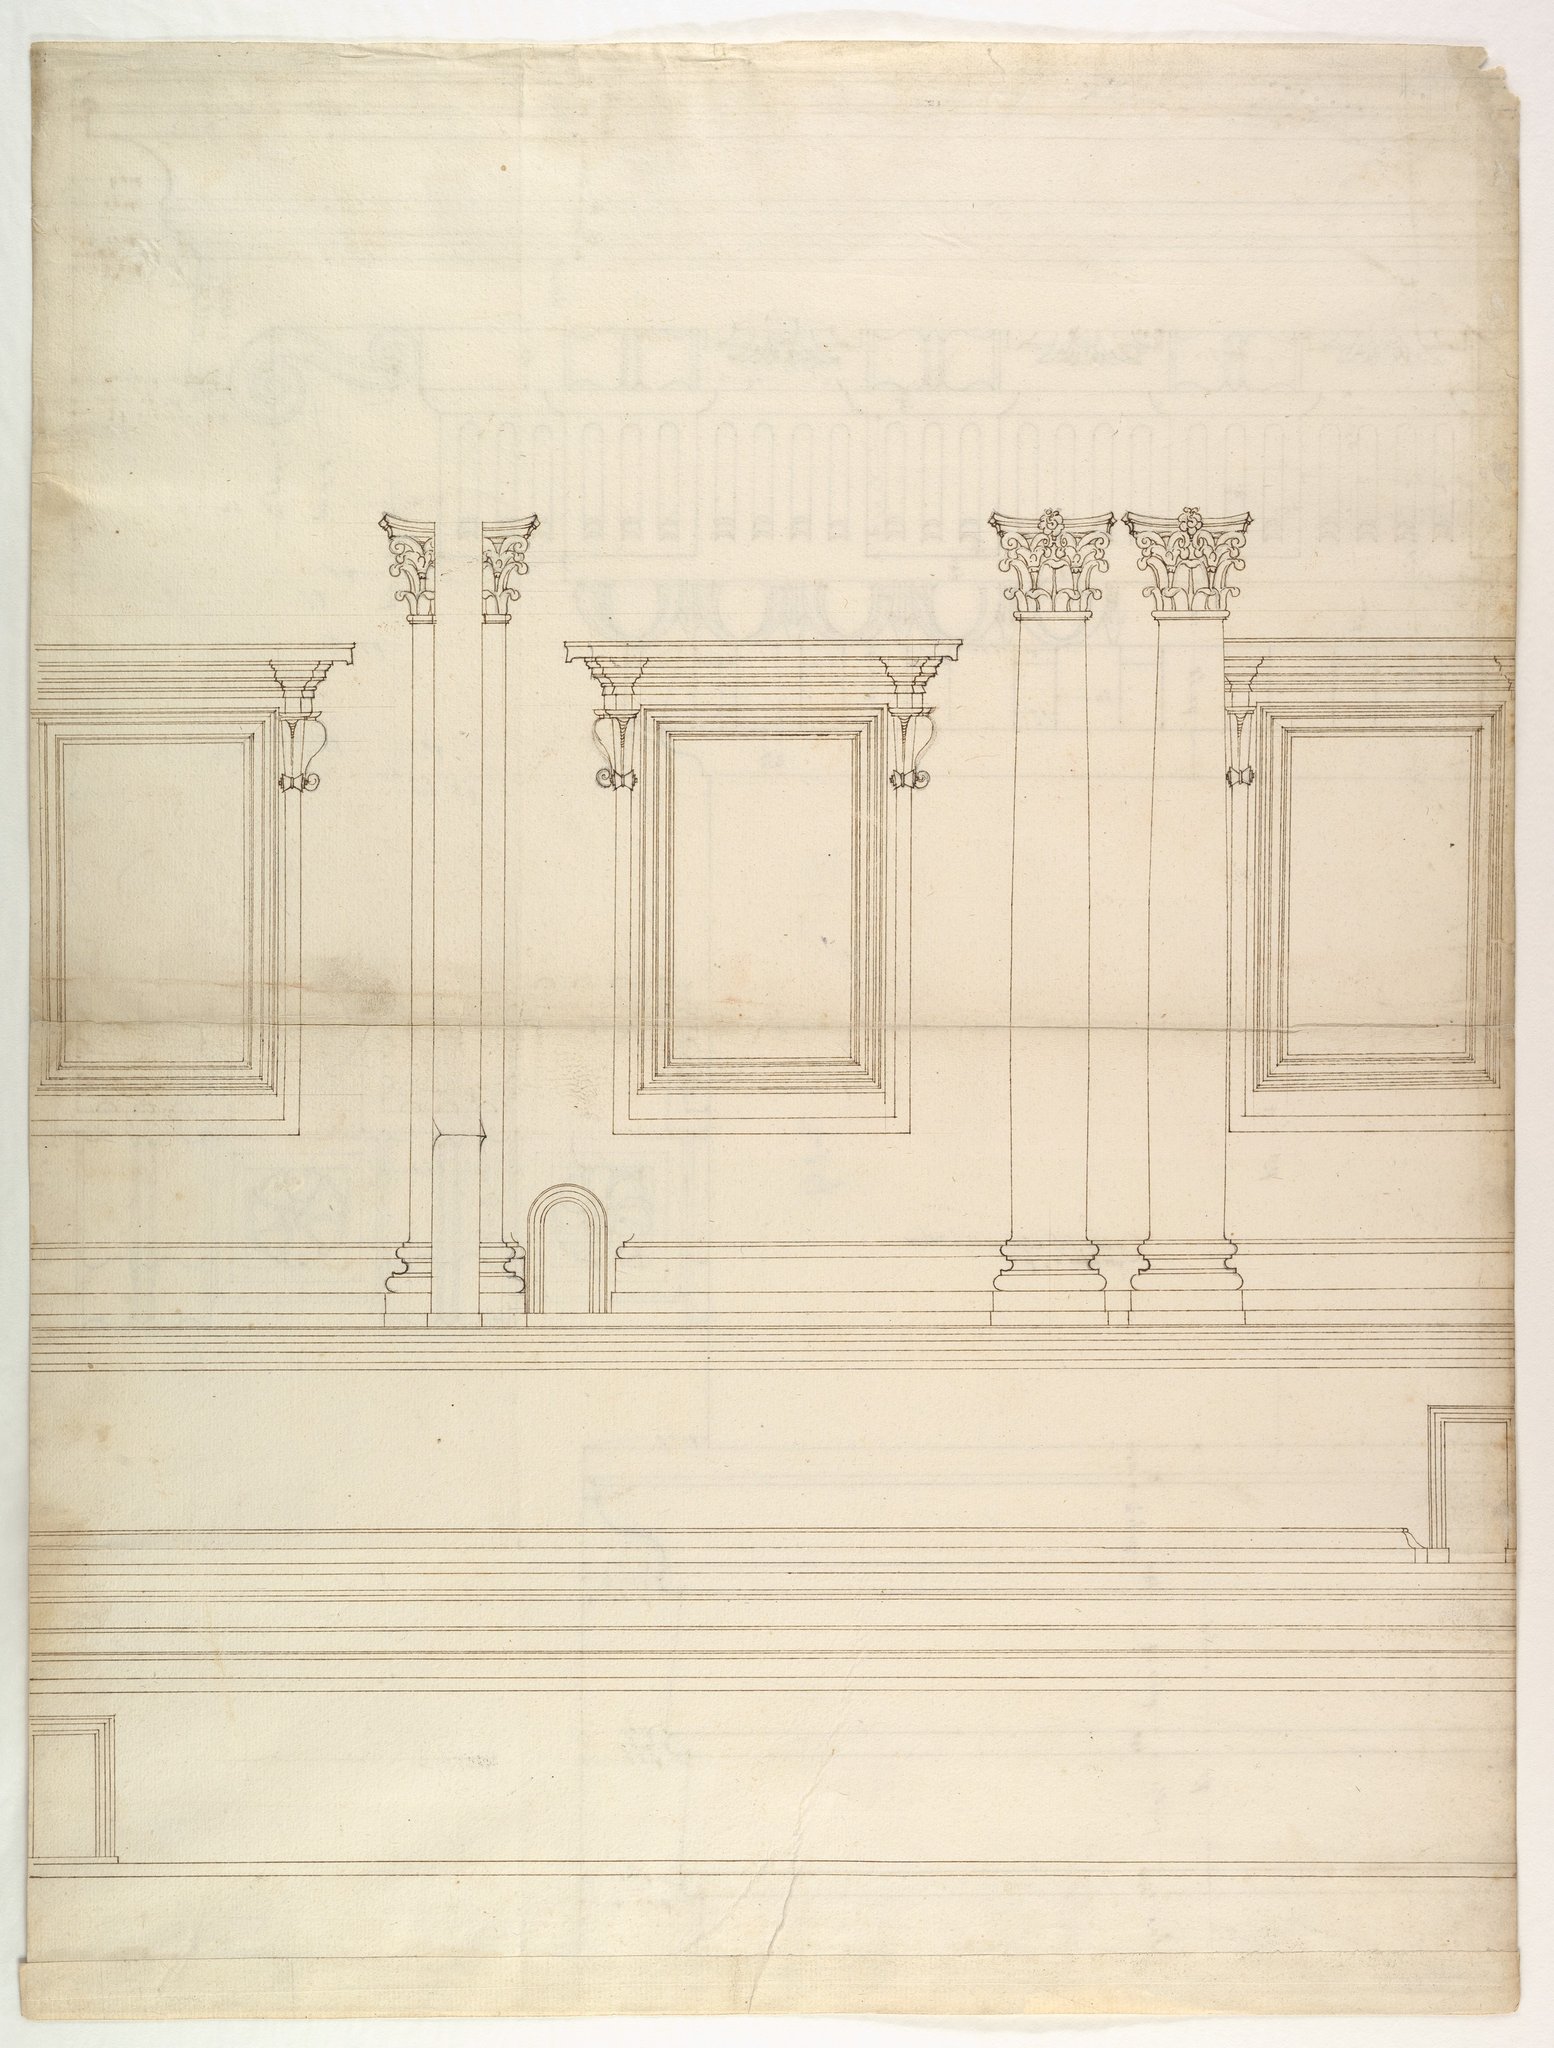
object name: drawing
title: St. Peter's, drum, exterior, elevation (recto) St. Peter's, tribune, entablature, section and details (verso)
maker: anonymous, french, 16th century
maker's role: draftsman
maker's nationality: french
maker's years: 1500-1600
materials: chalk, ink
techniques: incising, pen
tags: architecture